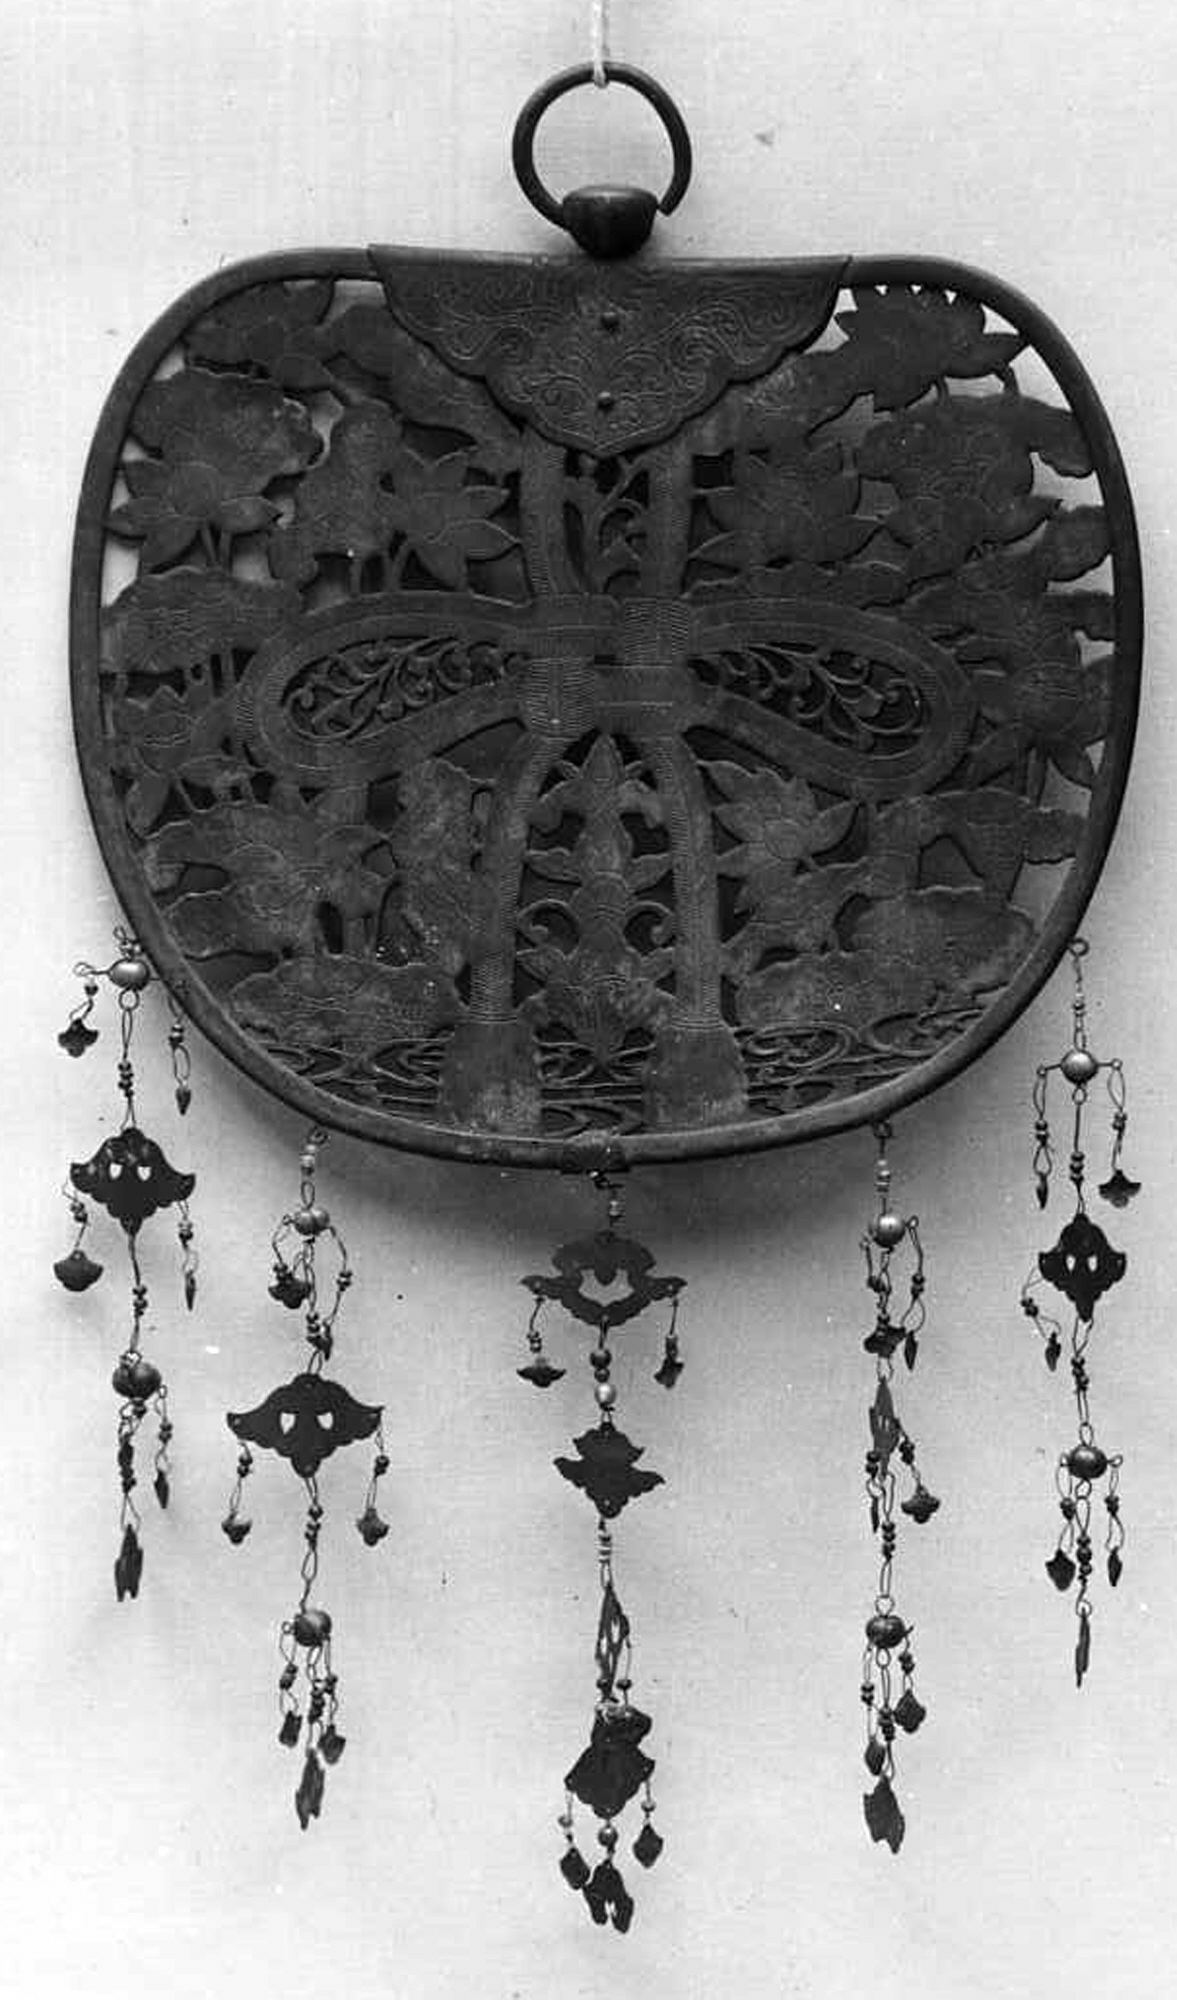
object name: temple decoration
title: Keman (“Flower Garland” Temple Decoration)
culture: japanese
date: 1725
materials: bronze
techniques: gilding